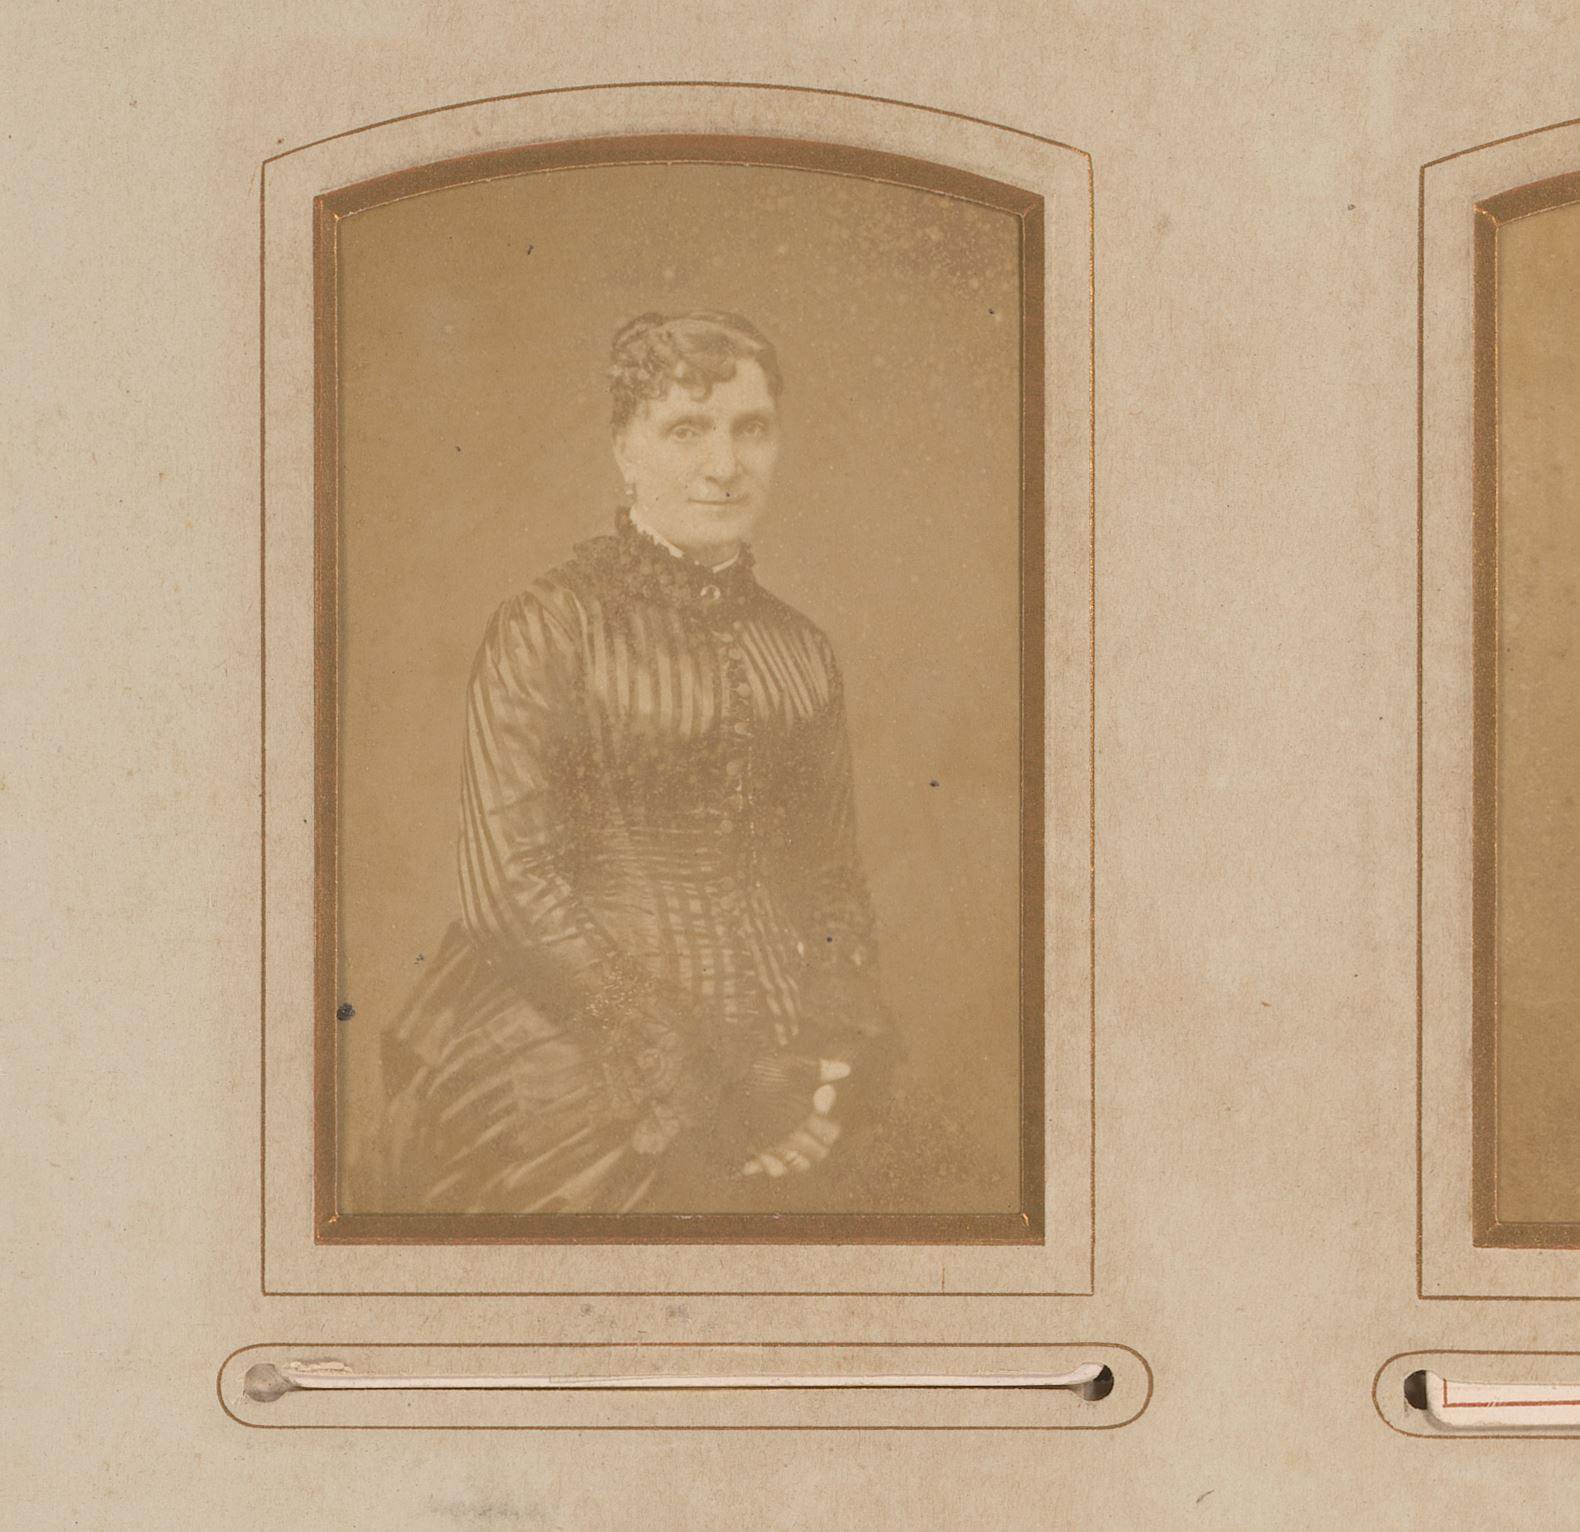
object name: album leaf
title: Portret van een vrouw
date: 1881-1887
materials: cardboard, photographic support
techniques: albumen print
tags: historical persons - bb - woman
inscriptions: inscription: ‘(...)/ Photographie/ inaltérable/ au charbon/ Auguste Despret/ BRUXELLES/ ancienne Mson Damry/ 43, rue du Pont Neuf (rue Neuve)/ NIVELLES/ Grand' Place 75/ Maison fondée/ en 1870./ Spécialité des grands portraits peints/ directement sur toile./ No... Tous les anciens clichés sont conservés.’